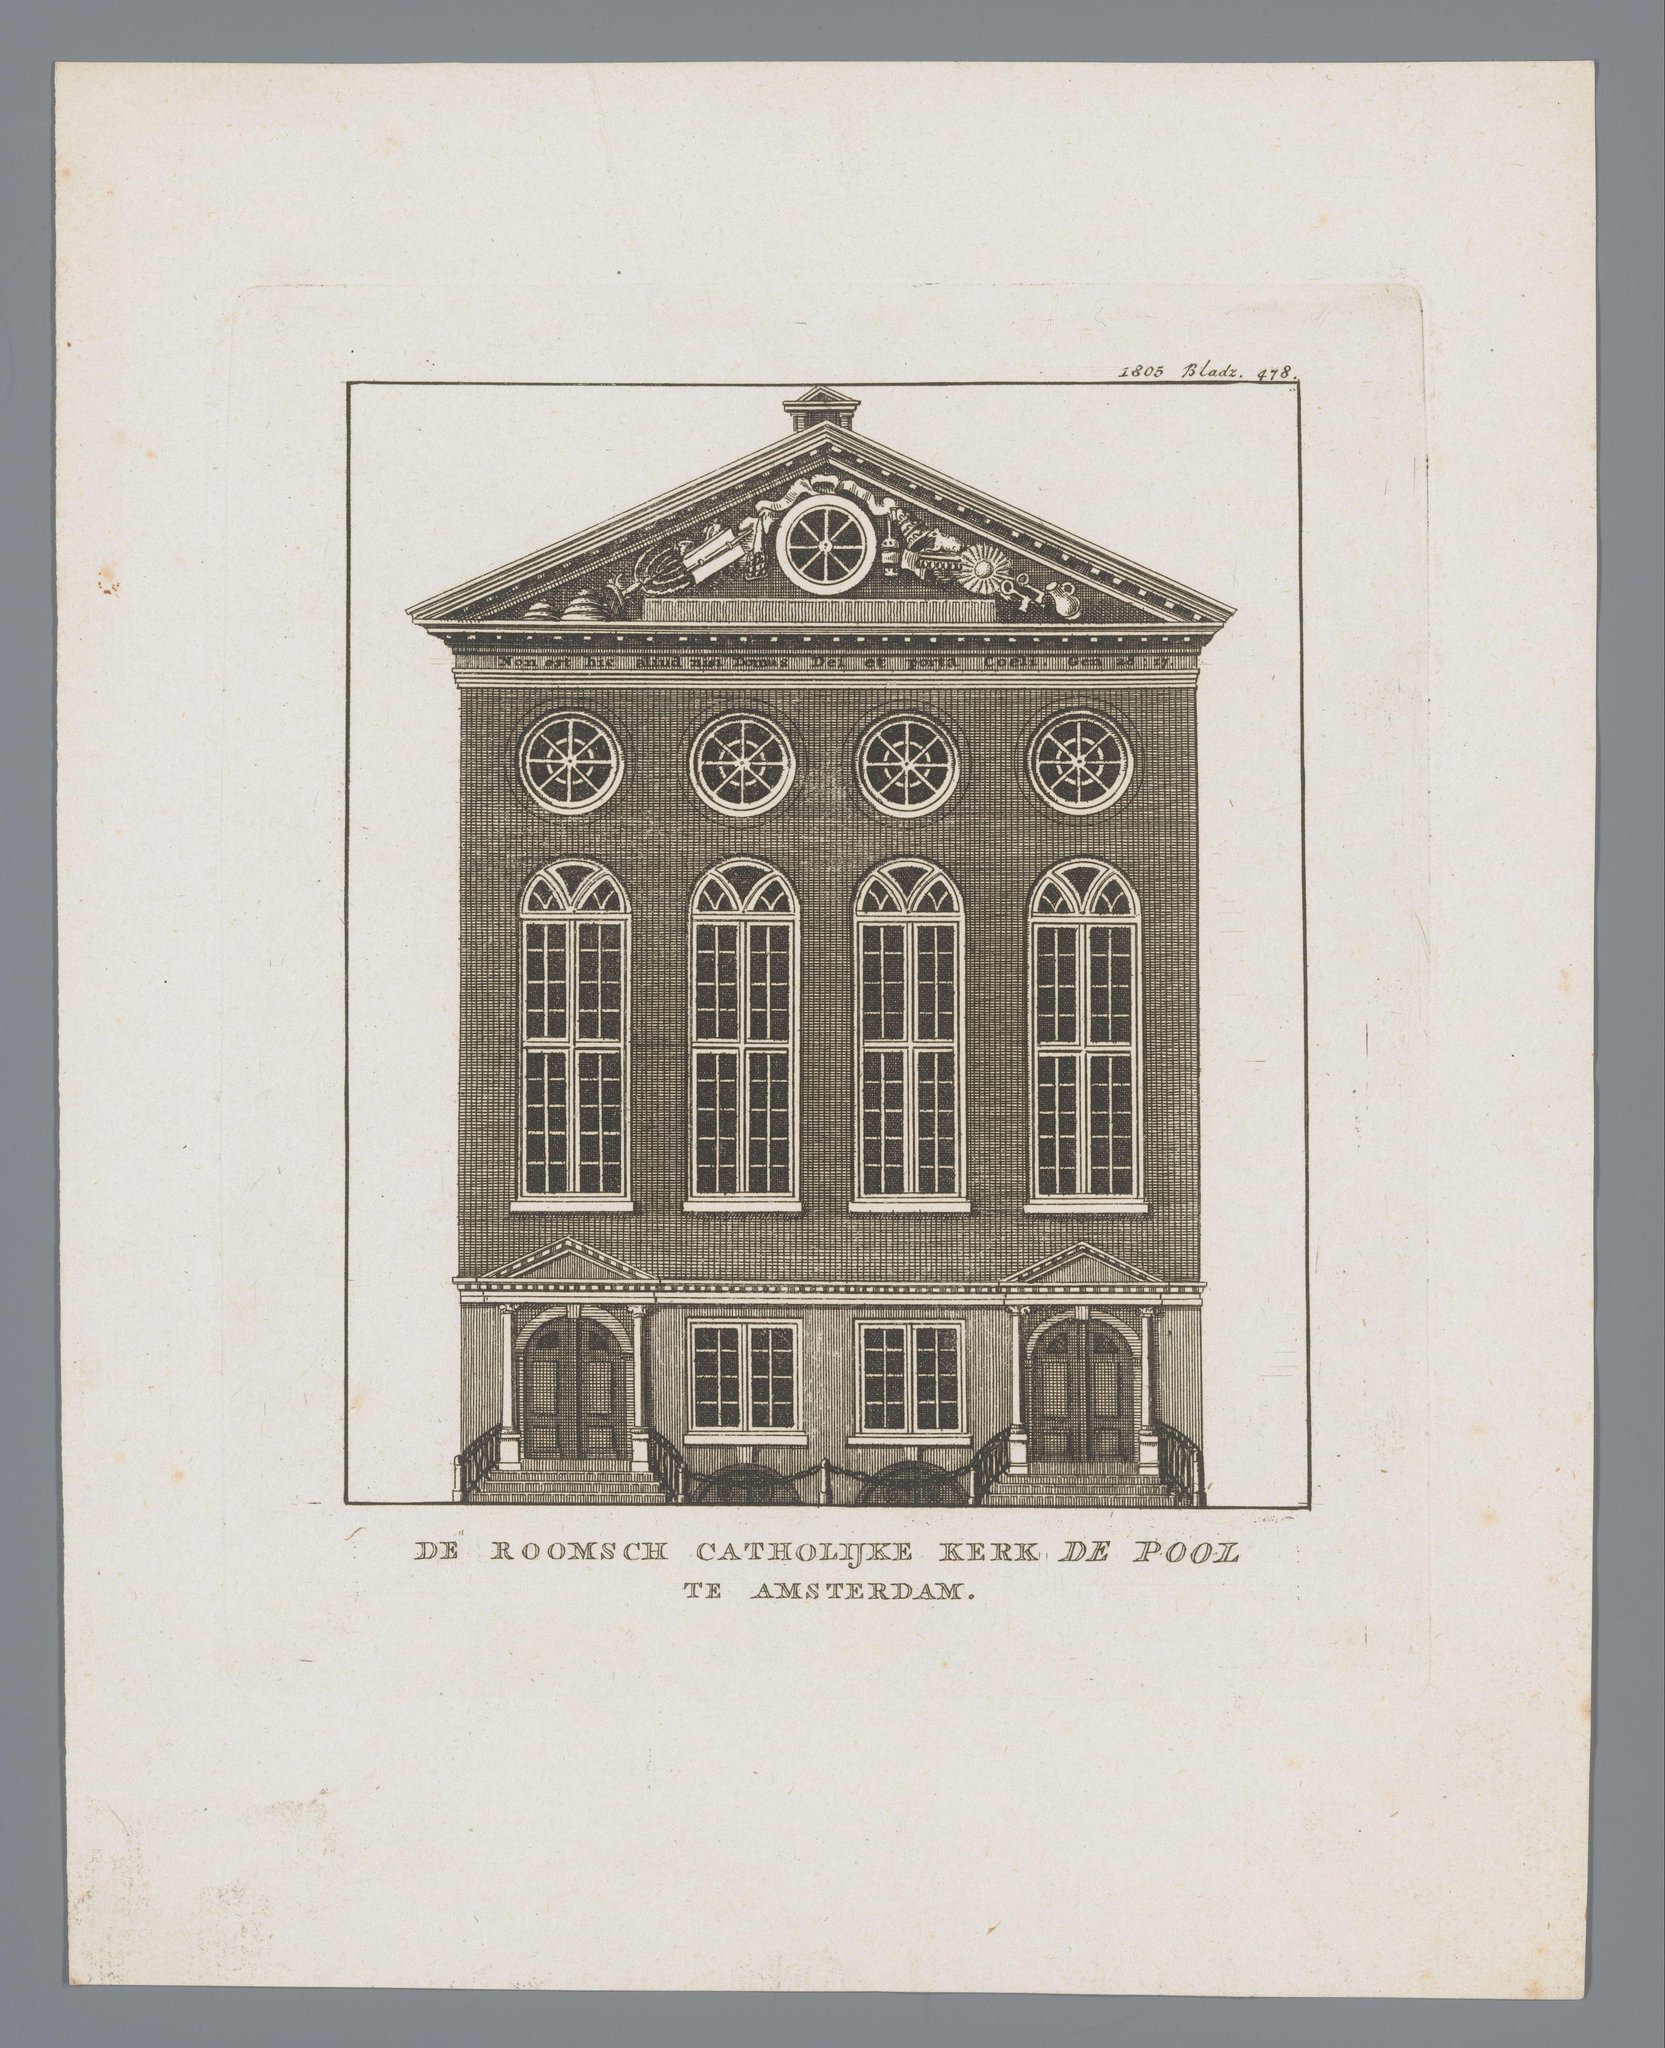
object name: print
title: Vooraanzicht van de Rooms Katholieke kerk De Pool te Amsterdam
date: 1805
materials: paper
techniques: etching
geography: amsterdam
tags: church (exterior), amsterdam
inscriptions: date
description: Prent uit: De Mercurius, 85 (1805), p. 478. De Rooms Katholieke kerk van de Heilige Anna, genaamd De Pool, aan de Buitenkant 30, later Prins Hendrikkade 188.